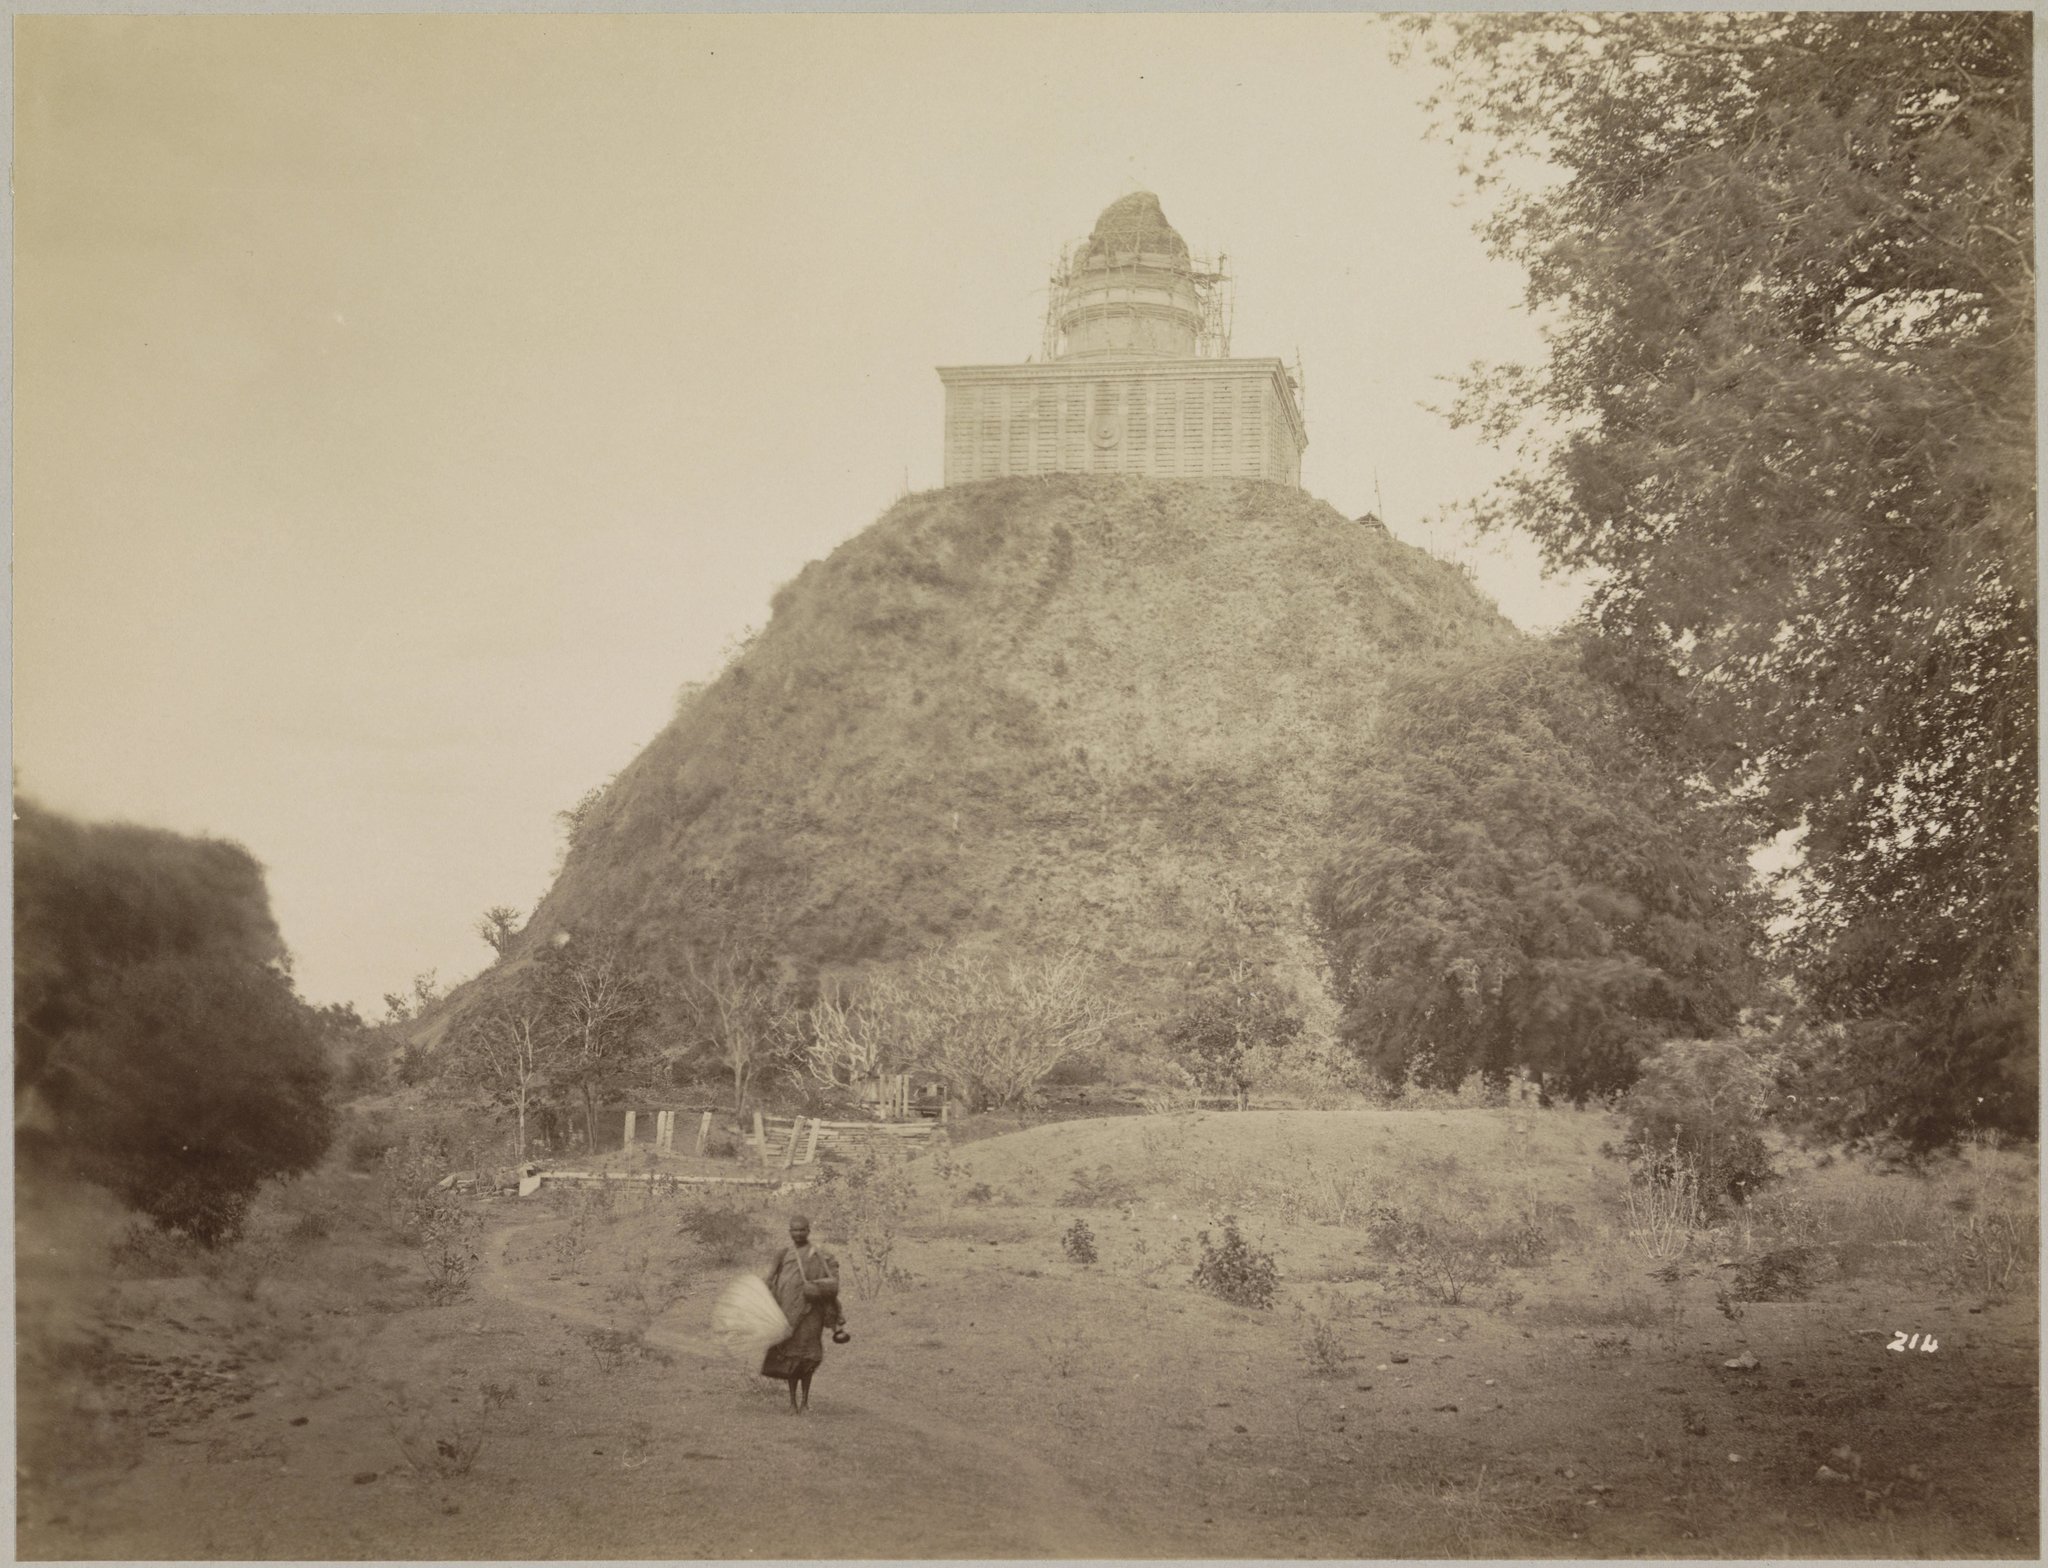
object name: photograph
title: View of the stupa, Anuradhapura, Sri Lanka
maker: Anonymous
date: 1895-1915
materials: cardboard, paper, photographic support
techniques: albumen print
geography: anuradhapura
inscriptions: number: ‘214’, inscription: ‘12 Anuradhapura.’